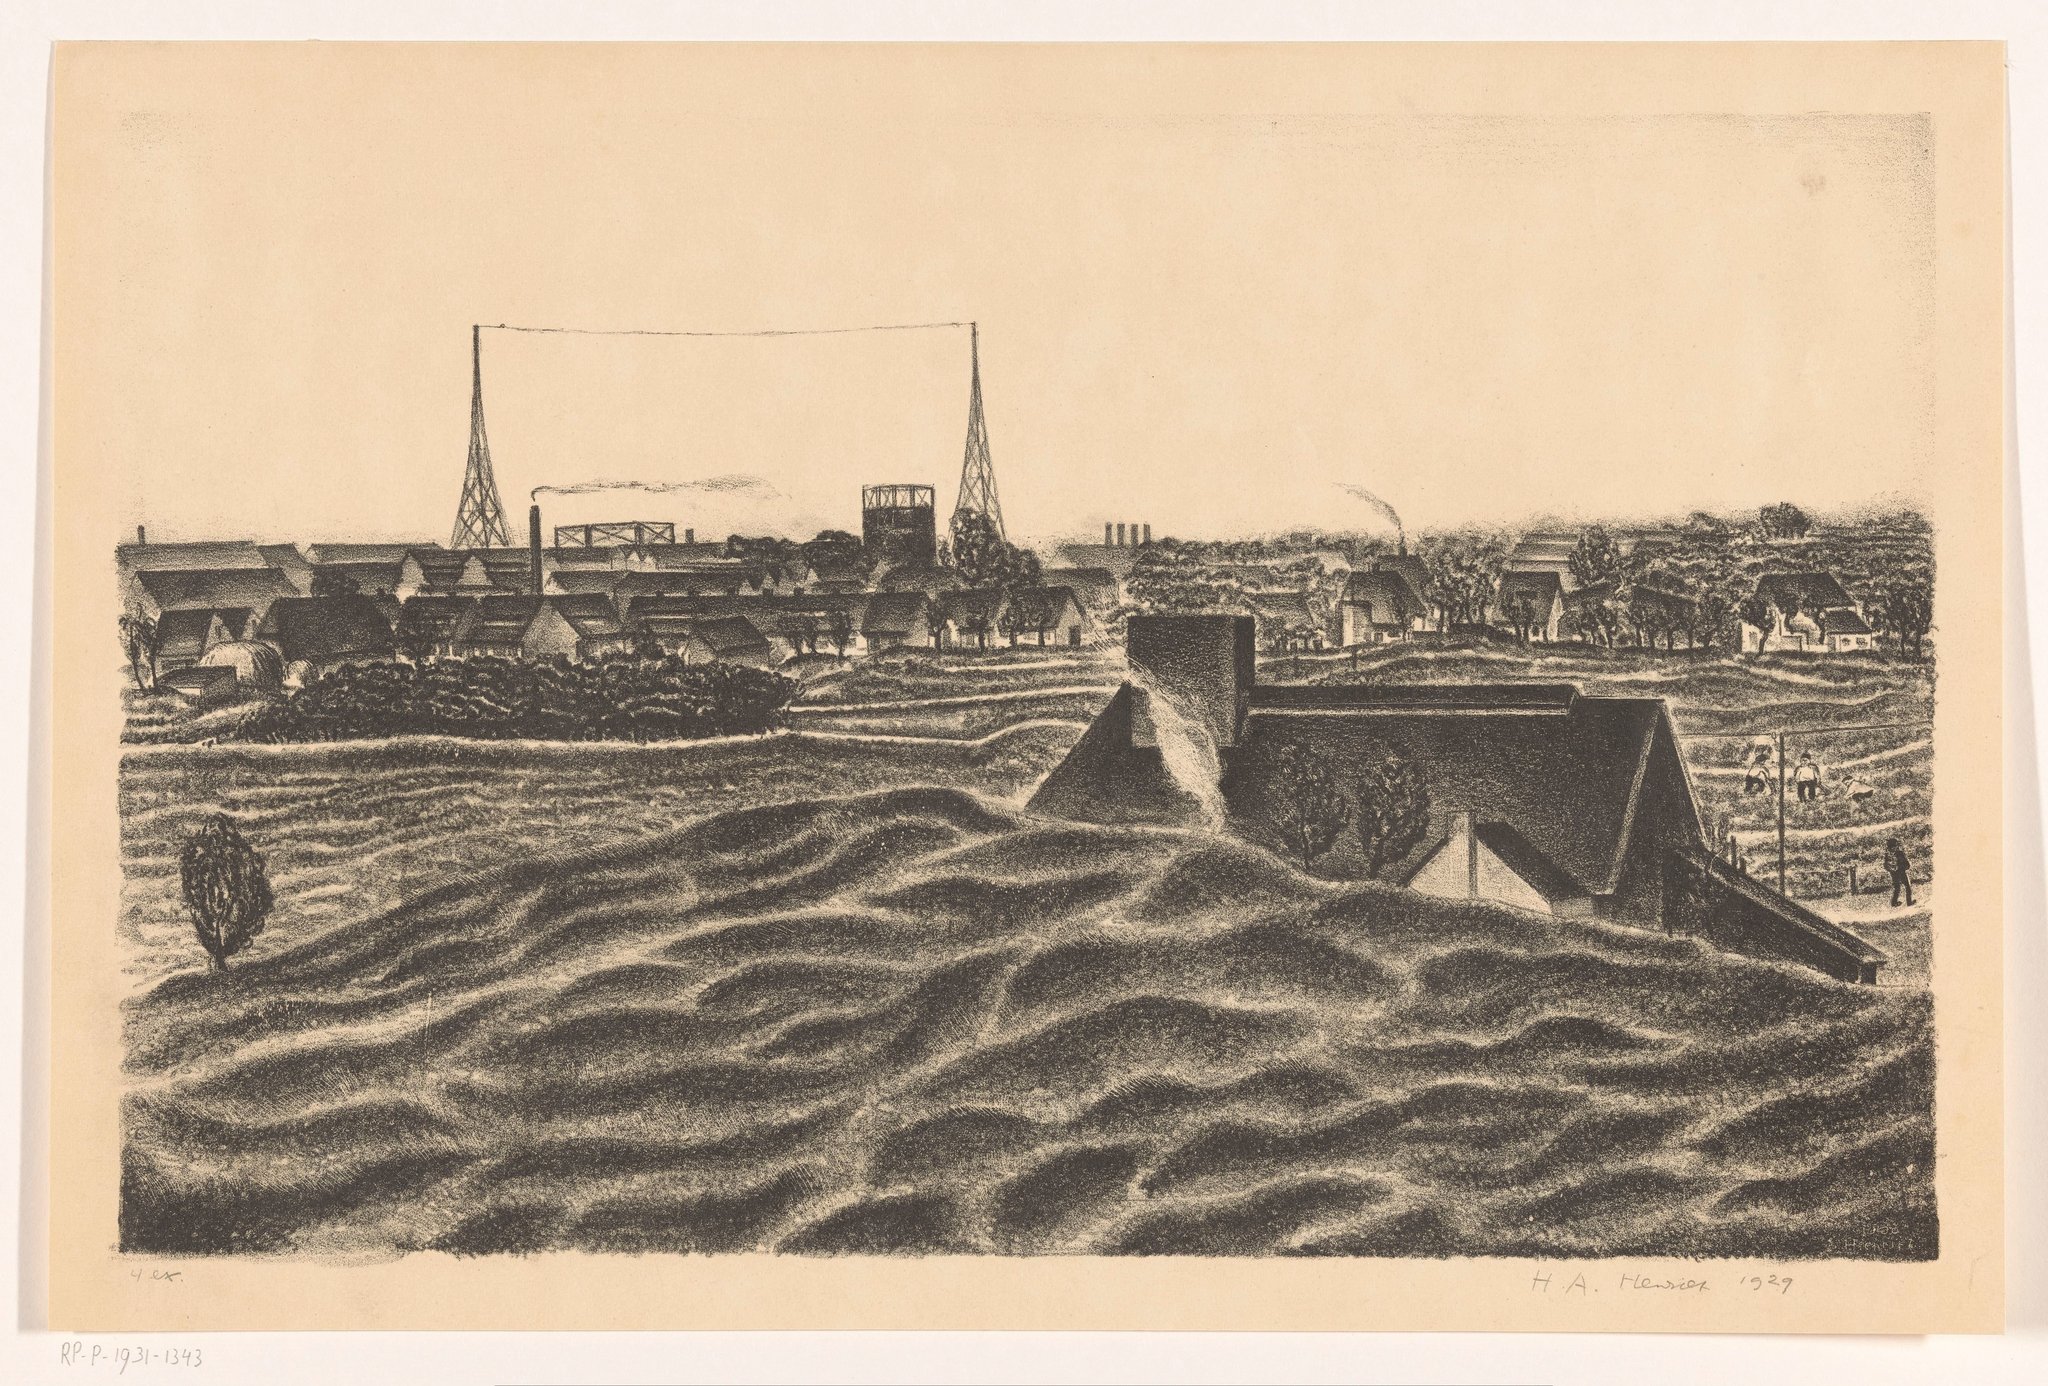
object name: print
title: Stadsrand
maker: henk henriët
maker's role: draughtsman, print maker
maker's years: 1903-1945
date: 1929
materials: paper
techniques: lithograph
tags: outskirts of city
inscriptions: collector's mark: Lugt 2228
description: Op de voorgrond een heuvel waarachter een huis staat. Op de achtergrond twee elektriciteitspalen.